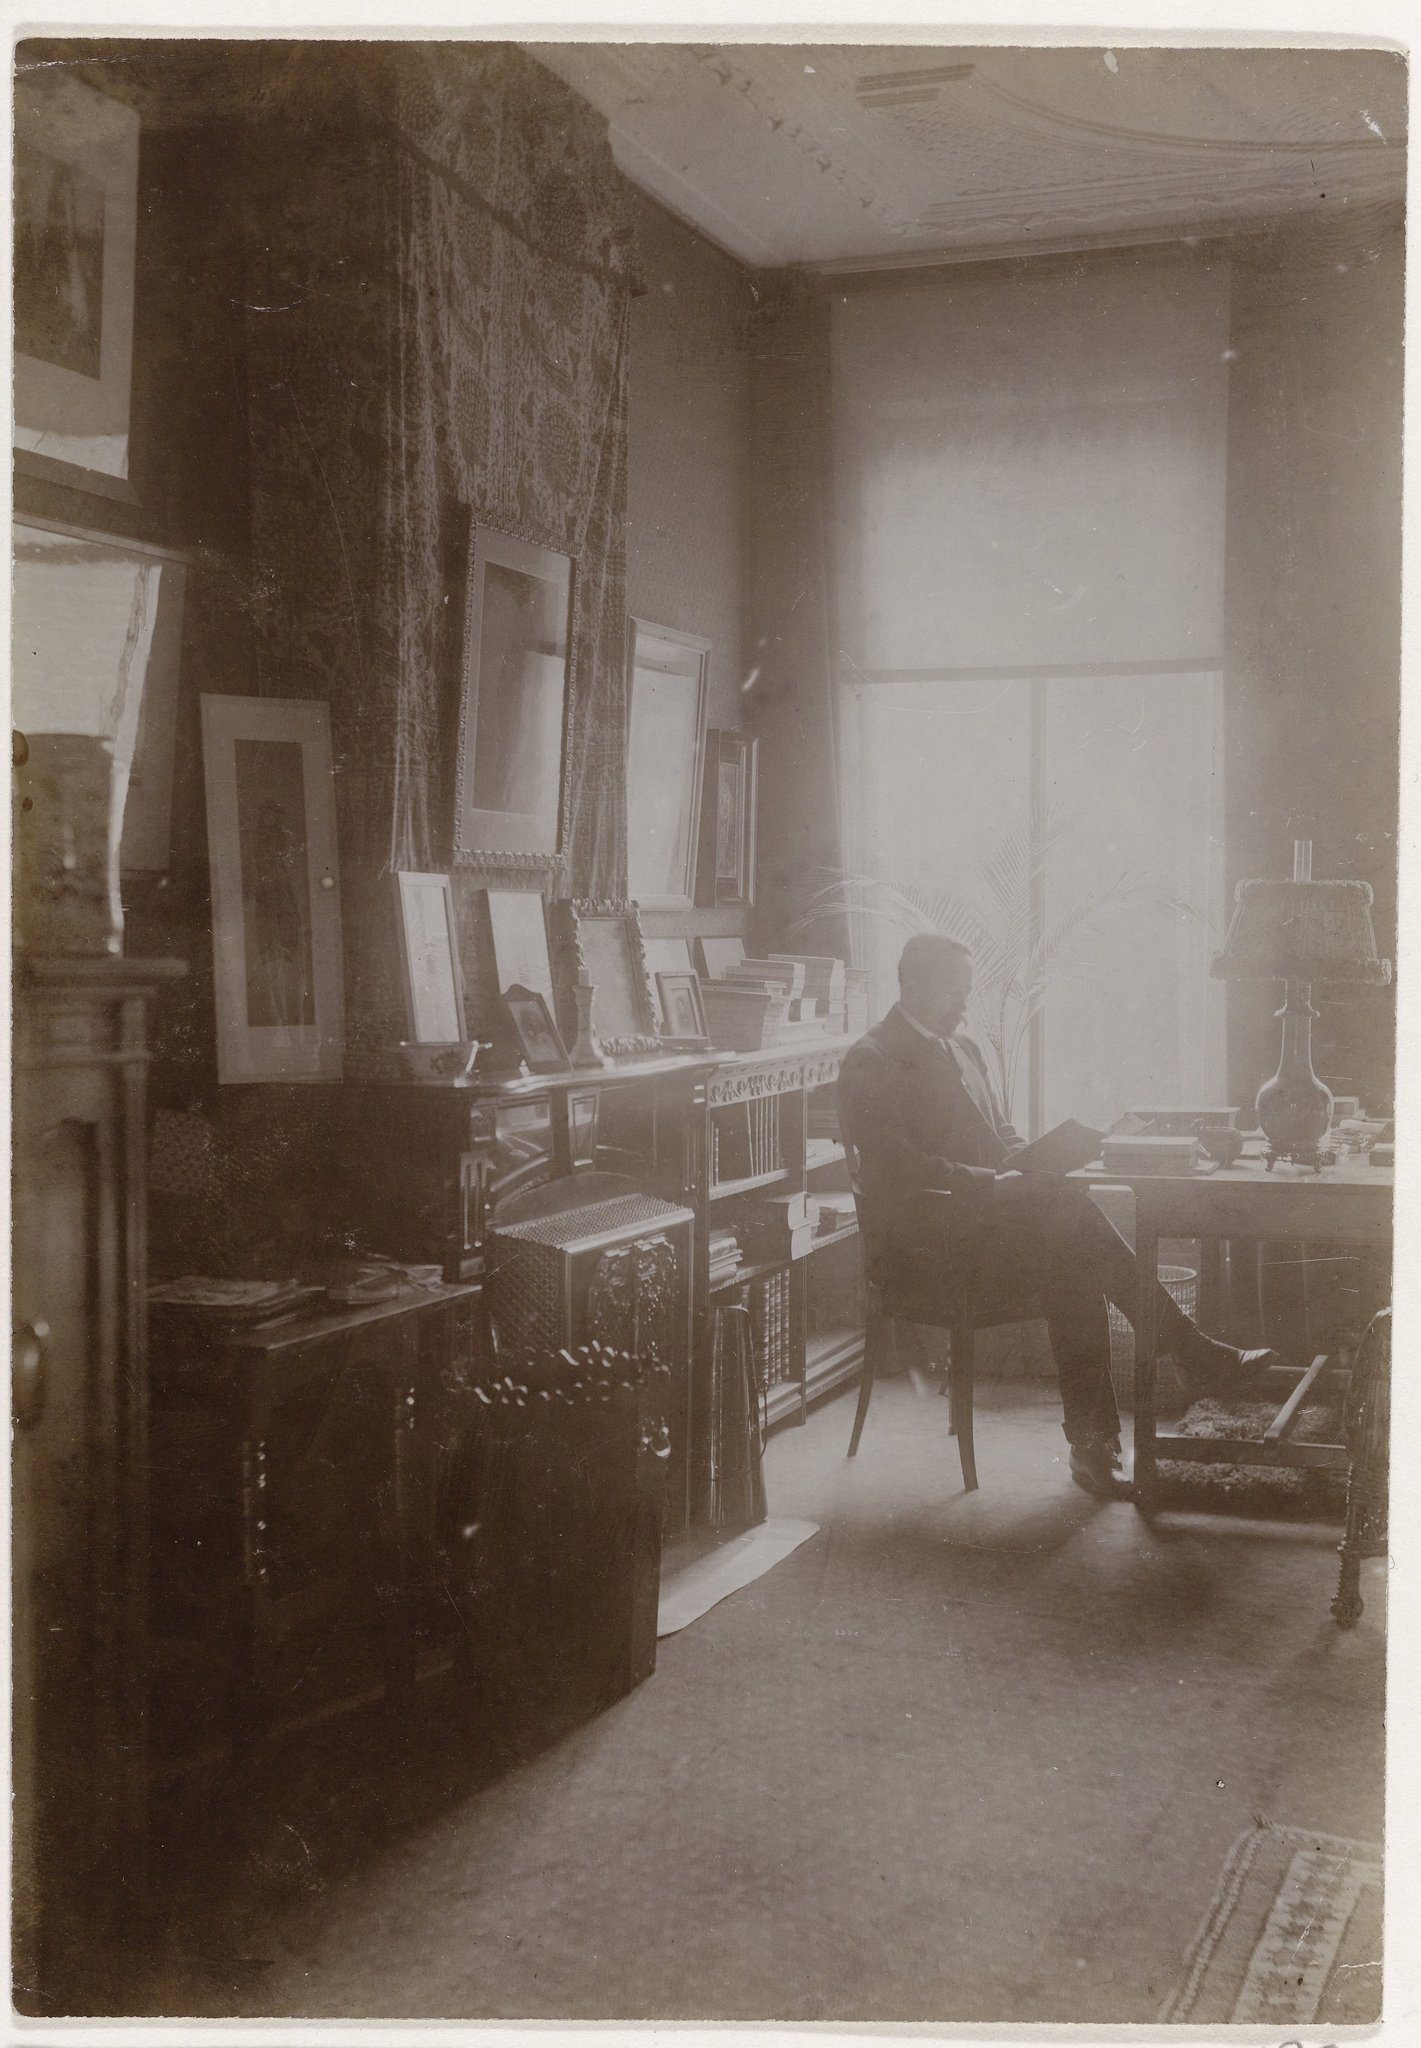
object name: photograph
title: Andries Bonger, aan tafel gezeten en lezend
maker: Anonymous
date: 1900-1920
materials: cardboard, paper, photographic support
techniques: collodion silver print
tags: andries bonger, reading, historical persons, other dwelling types, amsterdam